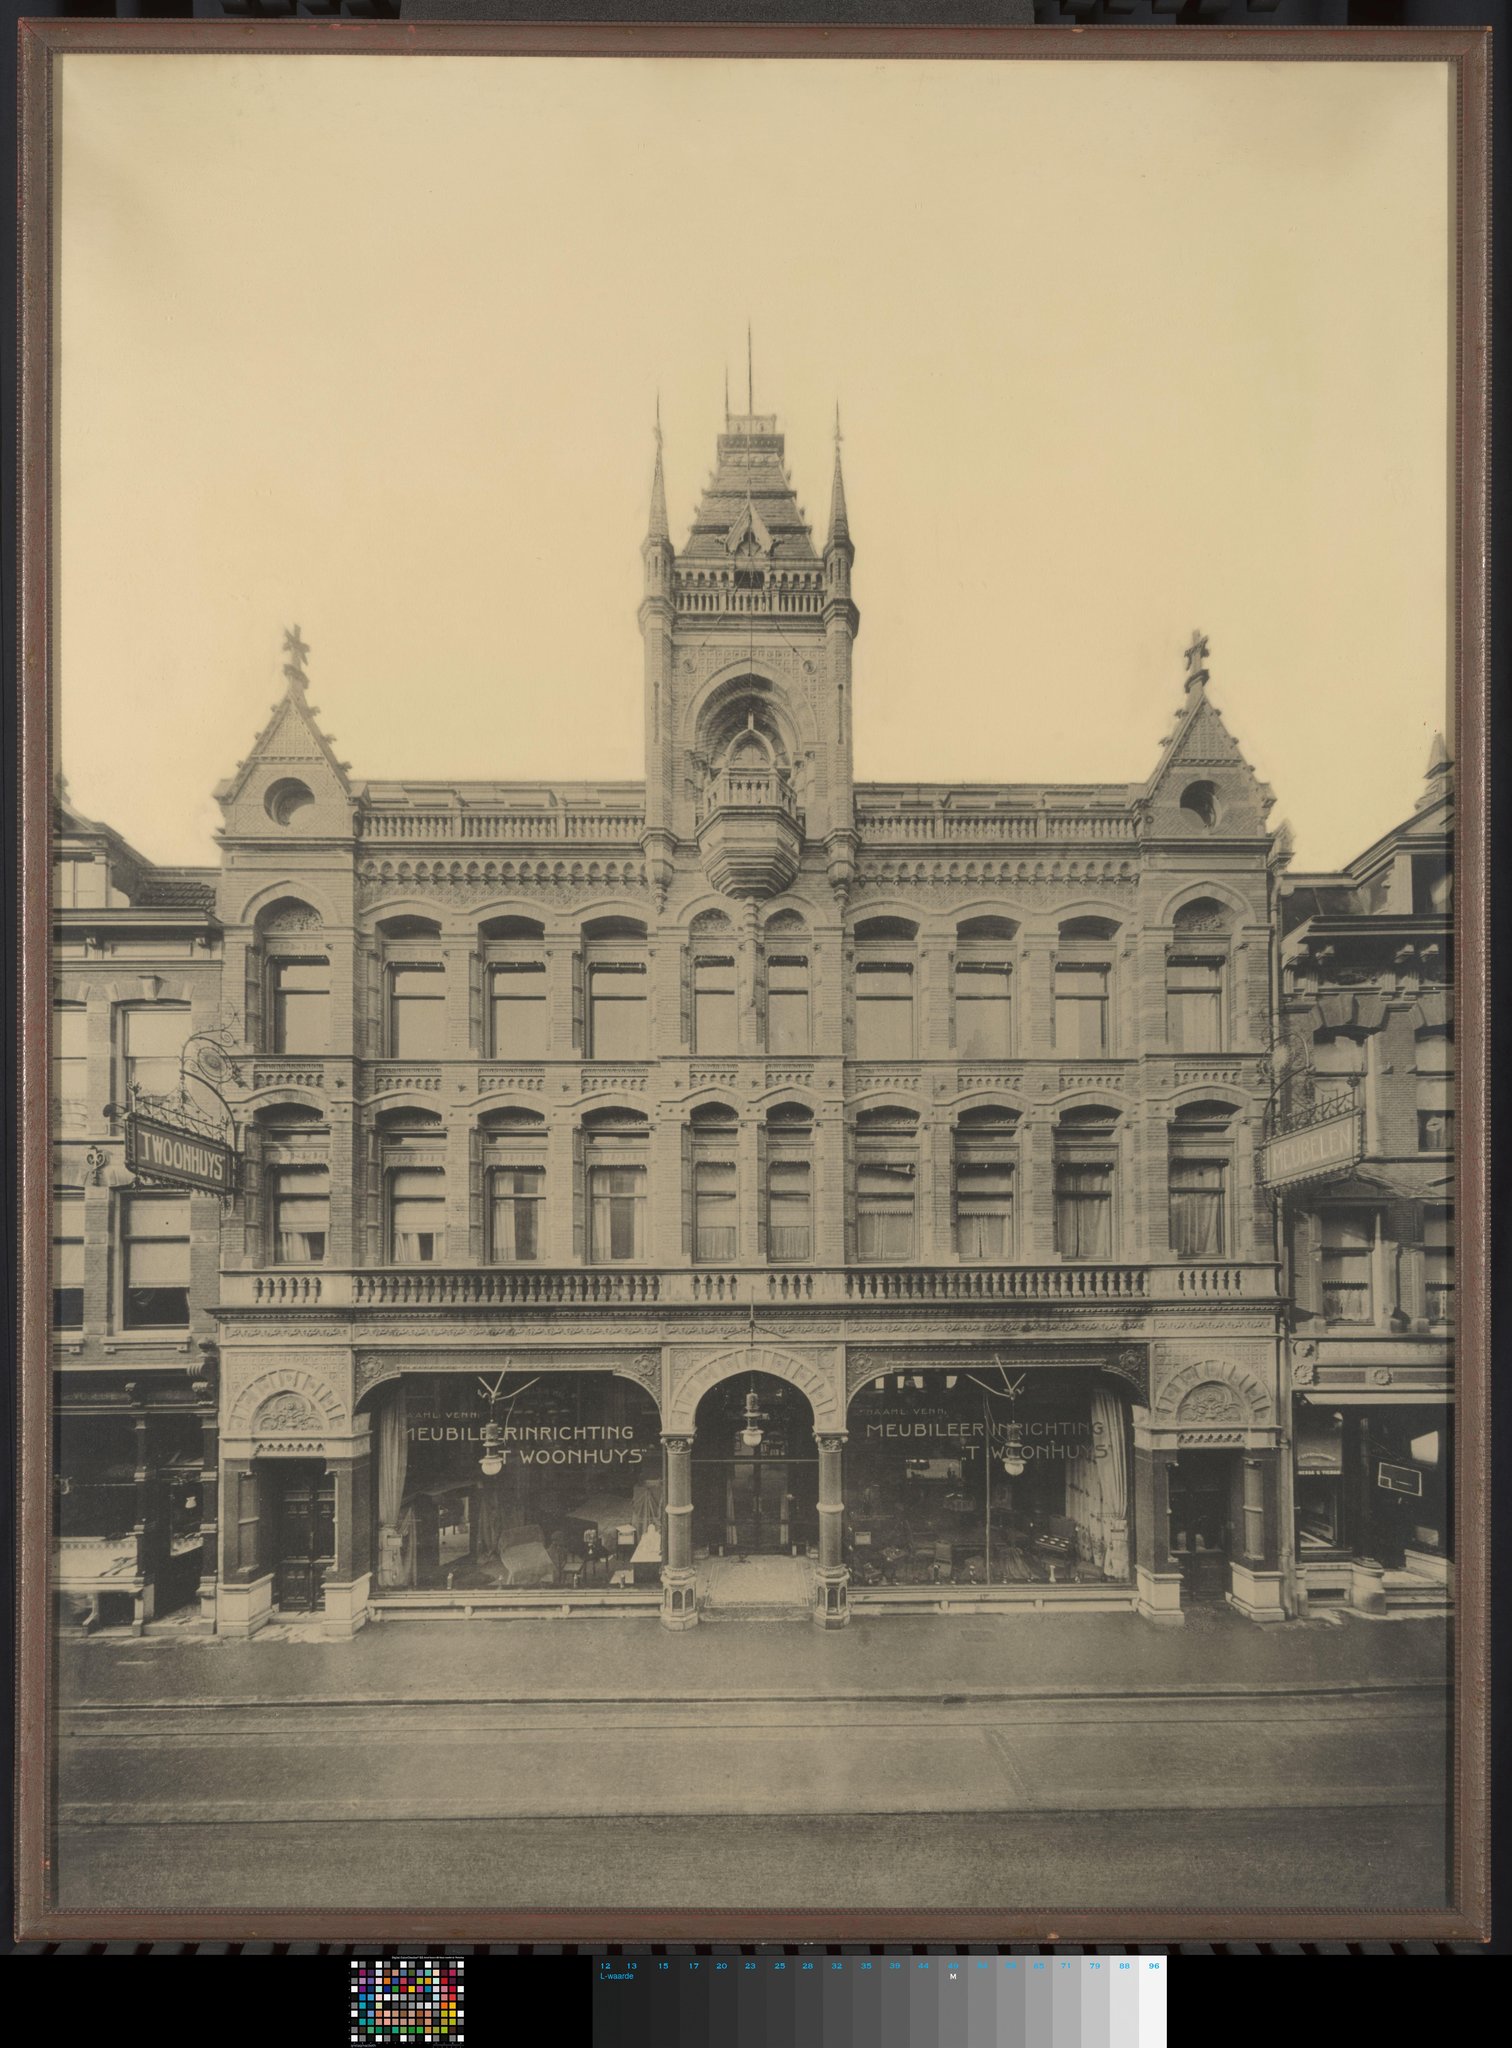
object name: photograph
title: Magazijn (winkel) van 't Woonhuys, Amsterdam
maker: Anonymous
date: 1925-1940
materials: cardboard, glass, photographic support, wood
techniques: gelatin silver print